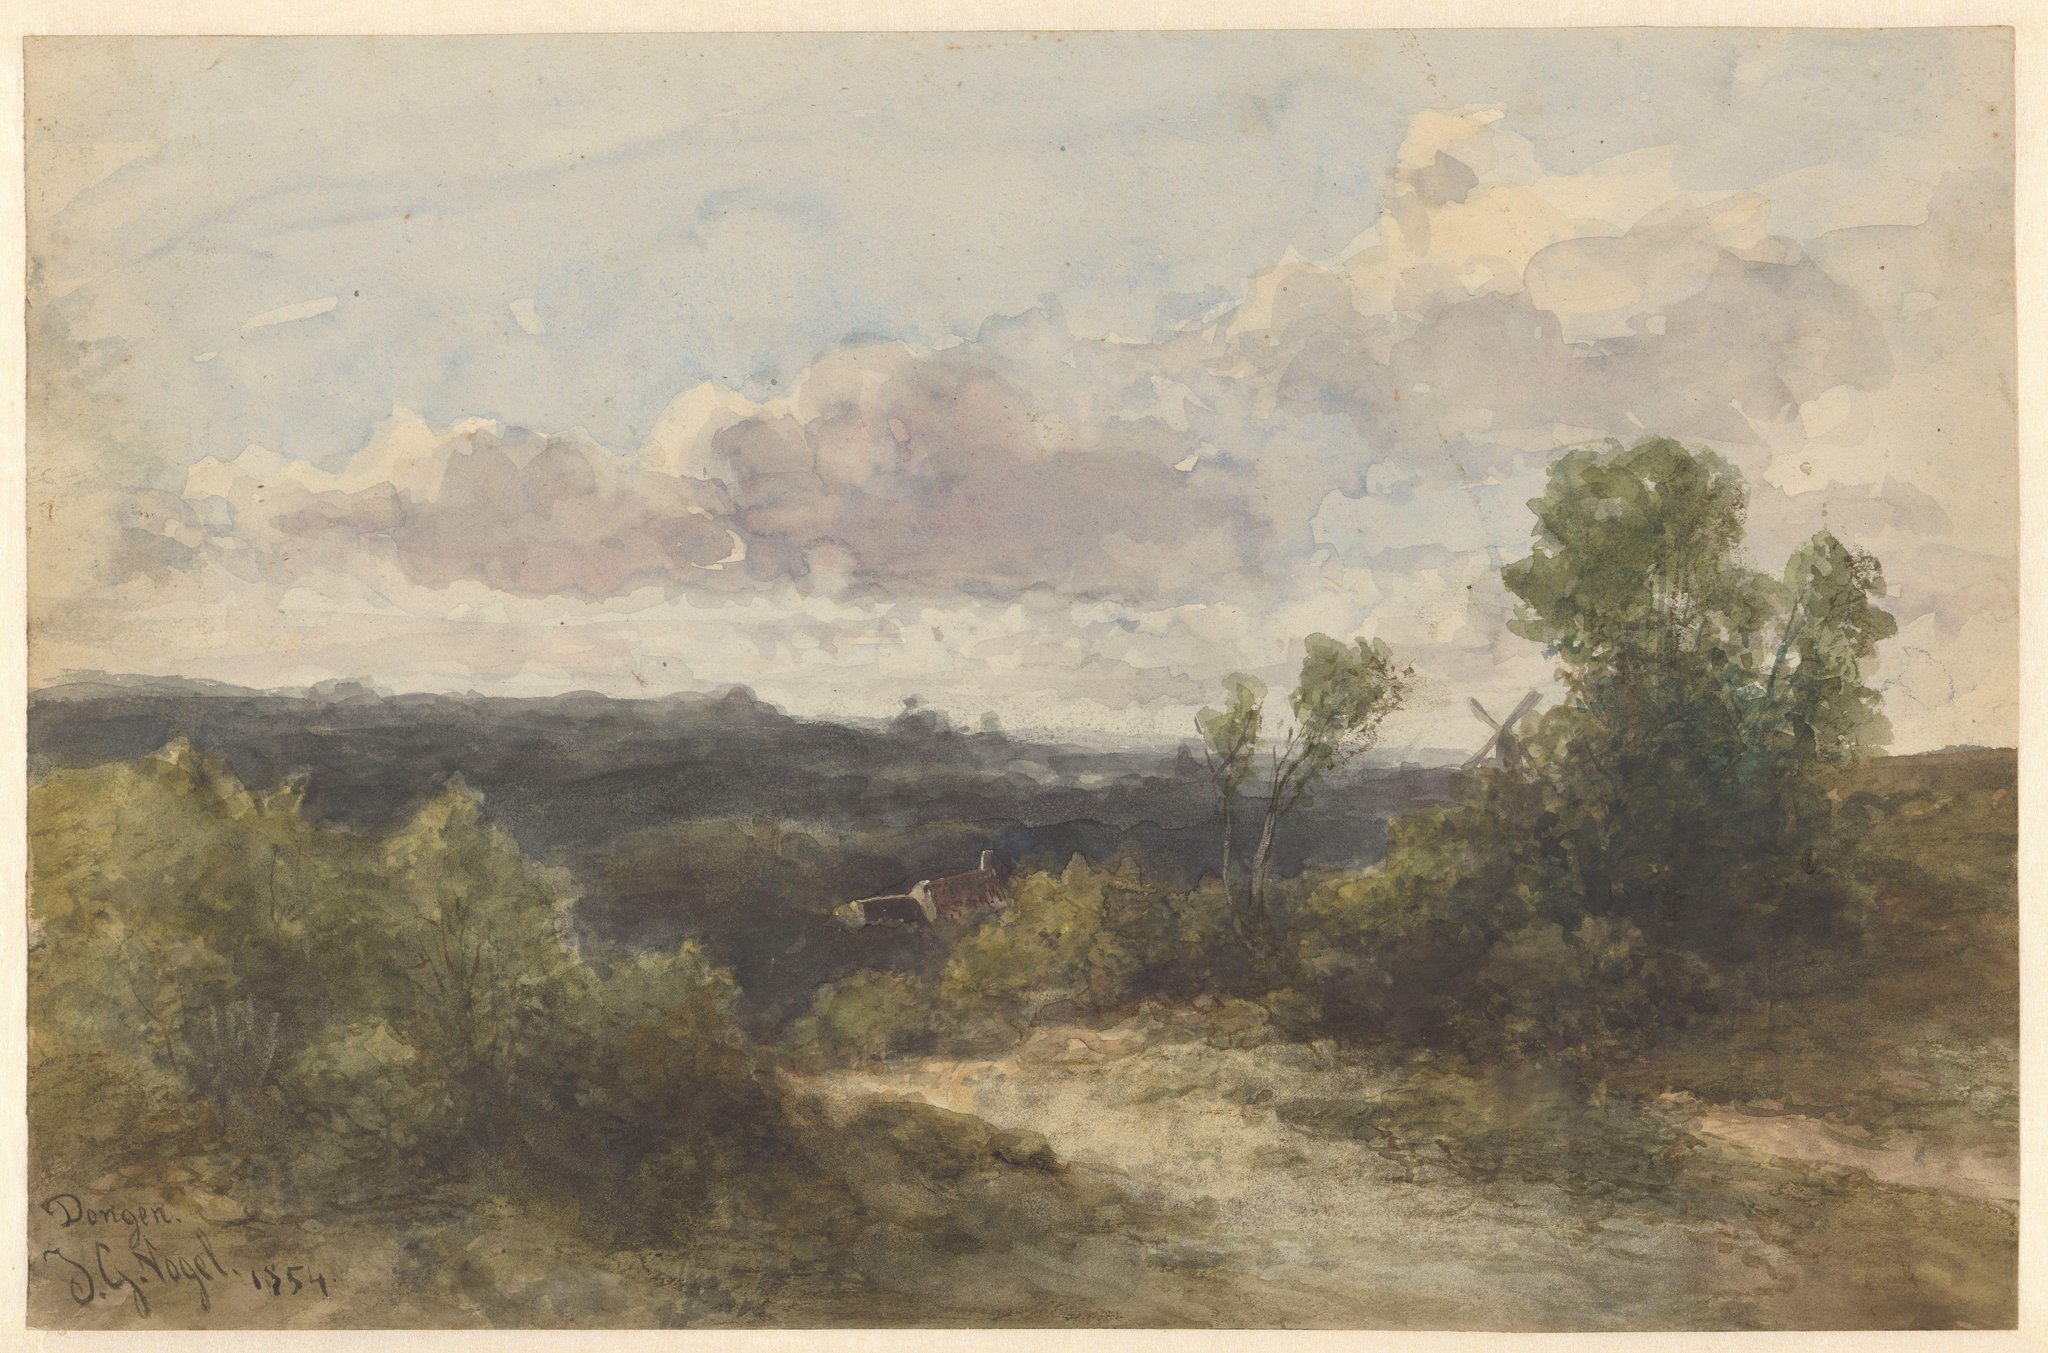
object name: drawing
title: Landschap bij Dongen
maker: johannes gijsbert vogel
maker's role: draughtsman, painter, print maker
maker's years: 1828-1915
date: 1854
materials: chalk, paint, paper, watercolor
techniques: brush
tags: landscapes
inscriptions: date and inscription: ‘Dongen./ 1854’, collector's mark: Lugt 1181b